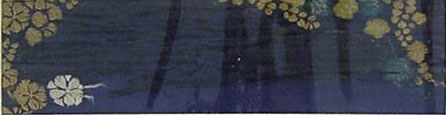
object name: piece from a kosode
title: Piece from a Kosode with Incomplete Floral Pattern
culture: japanese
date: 1615-1868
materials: gold leaf, silk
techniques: embroidery, weave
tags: flowers